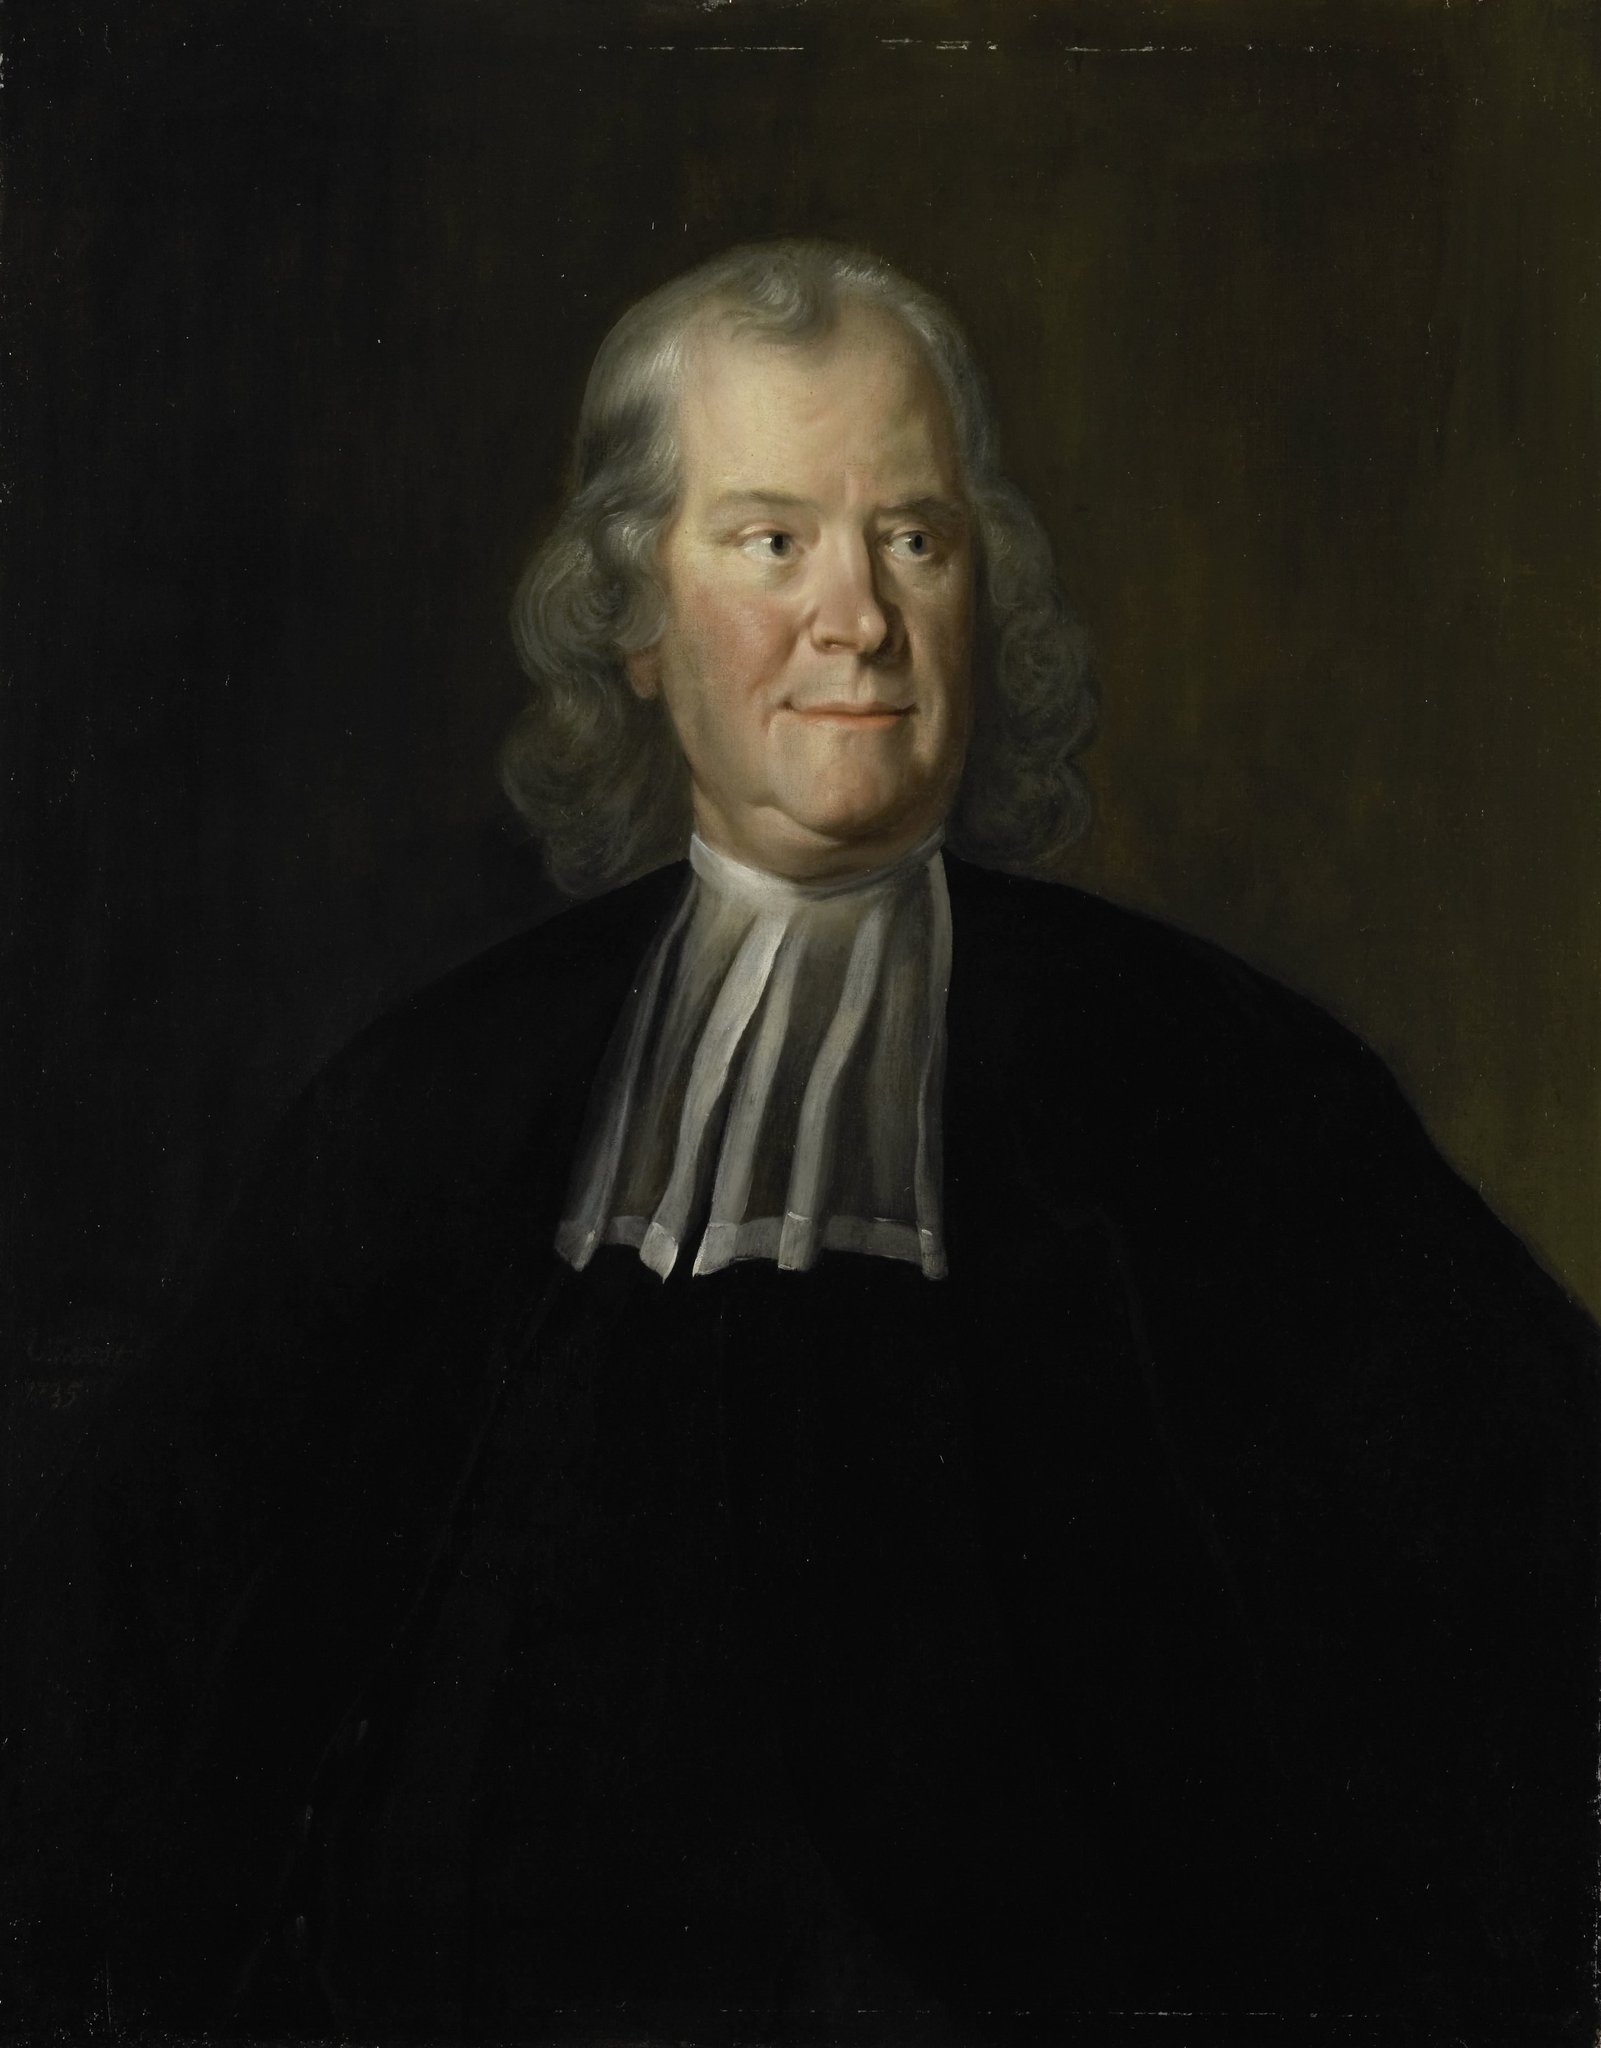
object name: painting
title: Portrait of the Physician Herman Boerhaave, Professor at the University of Leiden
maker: cornelis troost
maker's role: draughtsman, painter, print maker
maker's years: 1696-1750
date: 1735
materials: canvas, oil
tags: leiden, hermanus boerhaave, historical persons, professor, physician, doctor (+ scholar, scientist (at work))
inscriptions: signature and date: ‘C. Troost 1735’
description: Portret van Hermanus Boerhaave (1668-1738), geneeskundige, hoogleraar aan de universiteit te Leiden. Ten halven lijve, het gezicht naar rechts gewend.